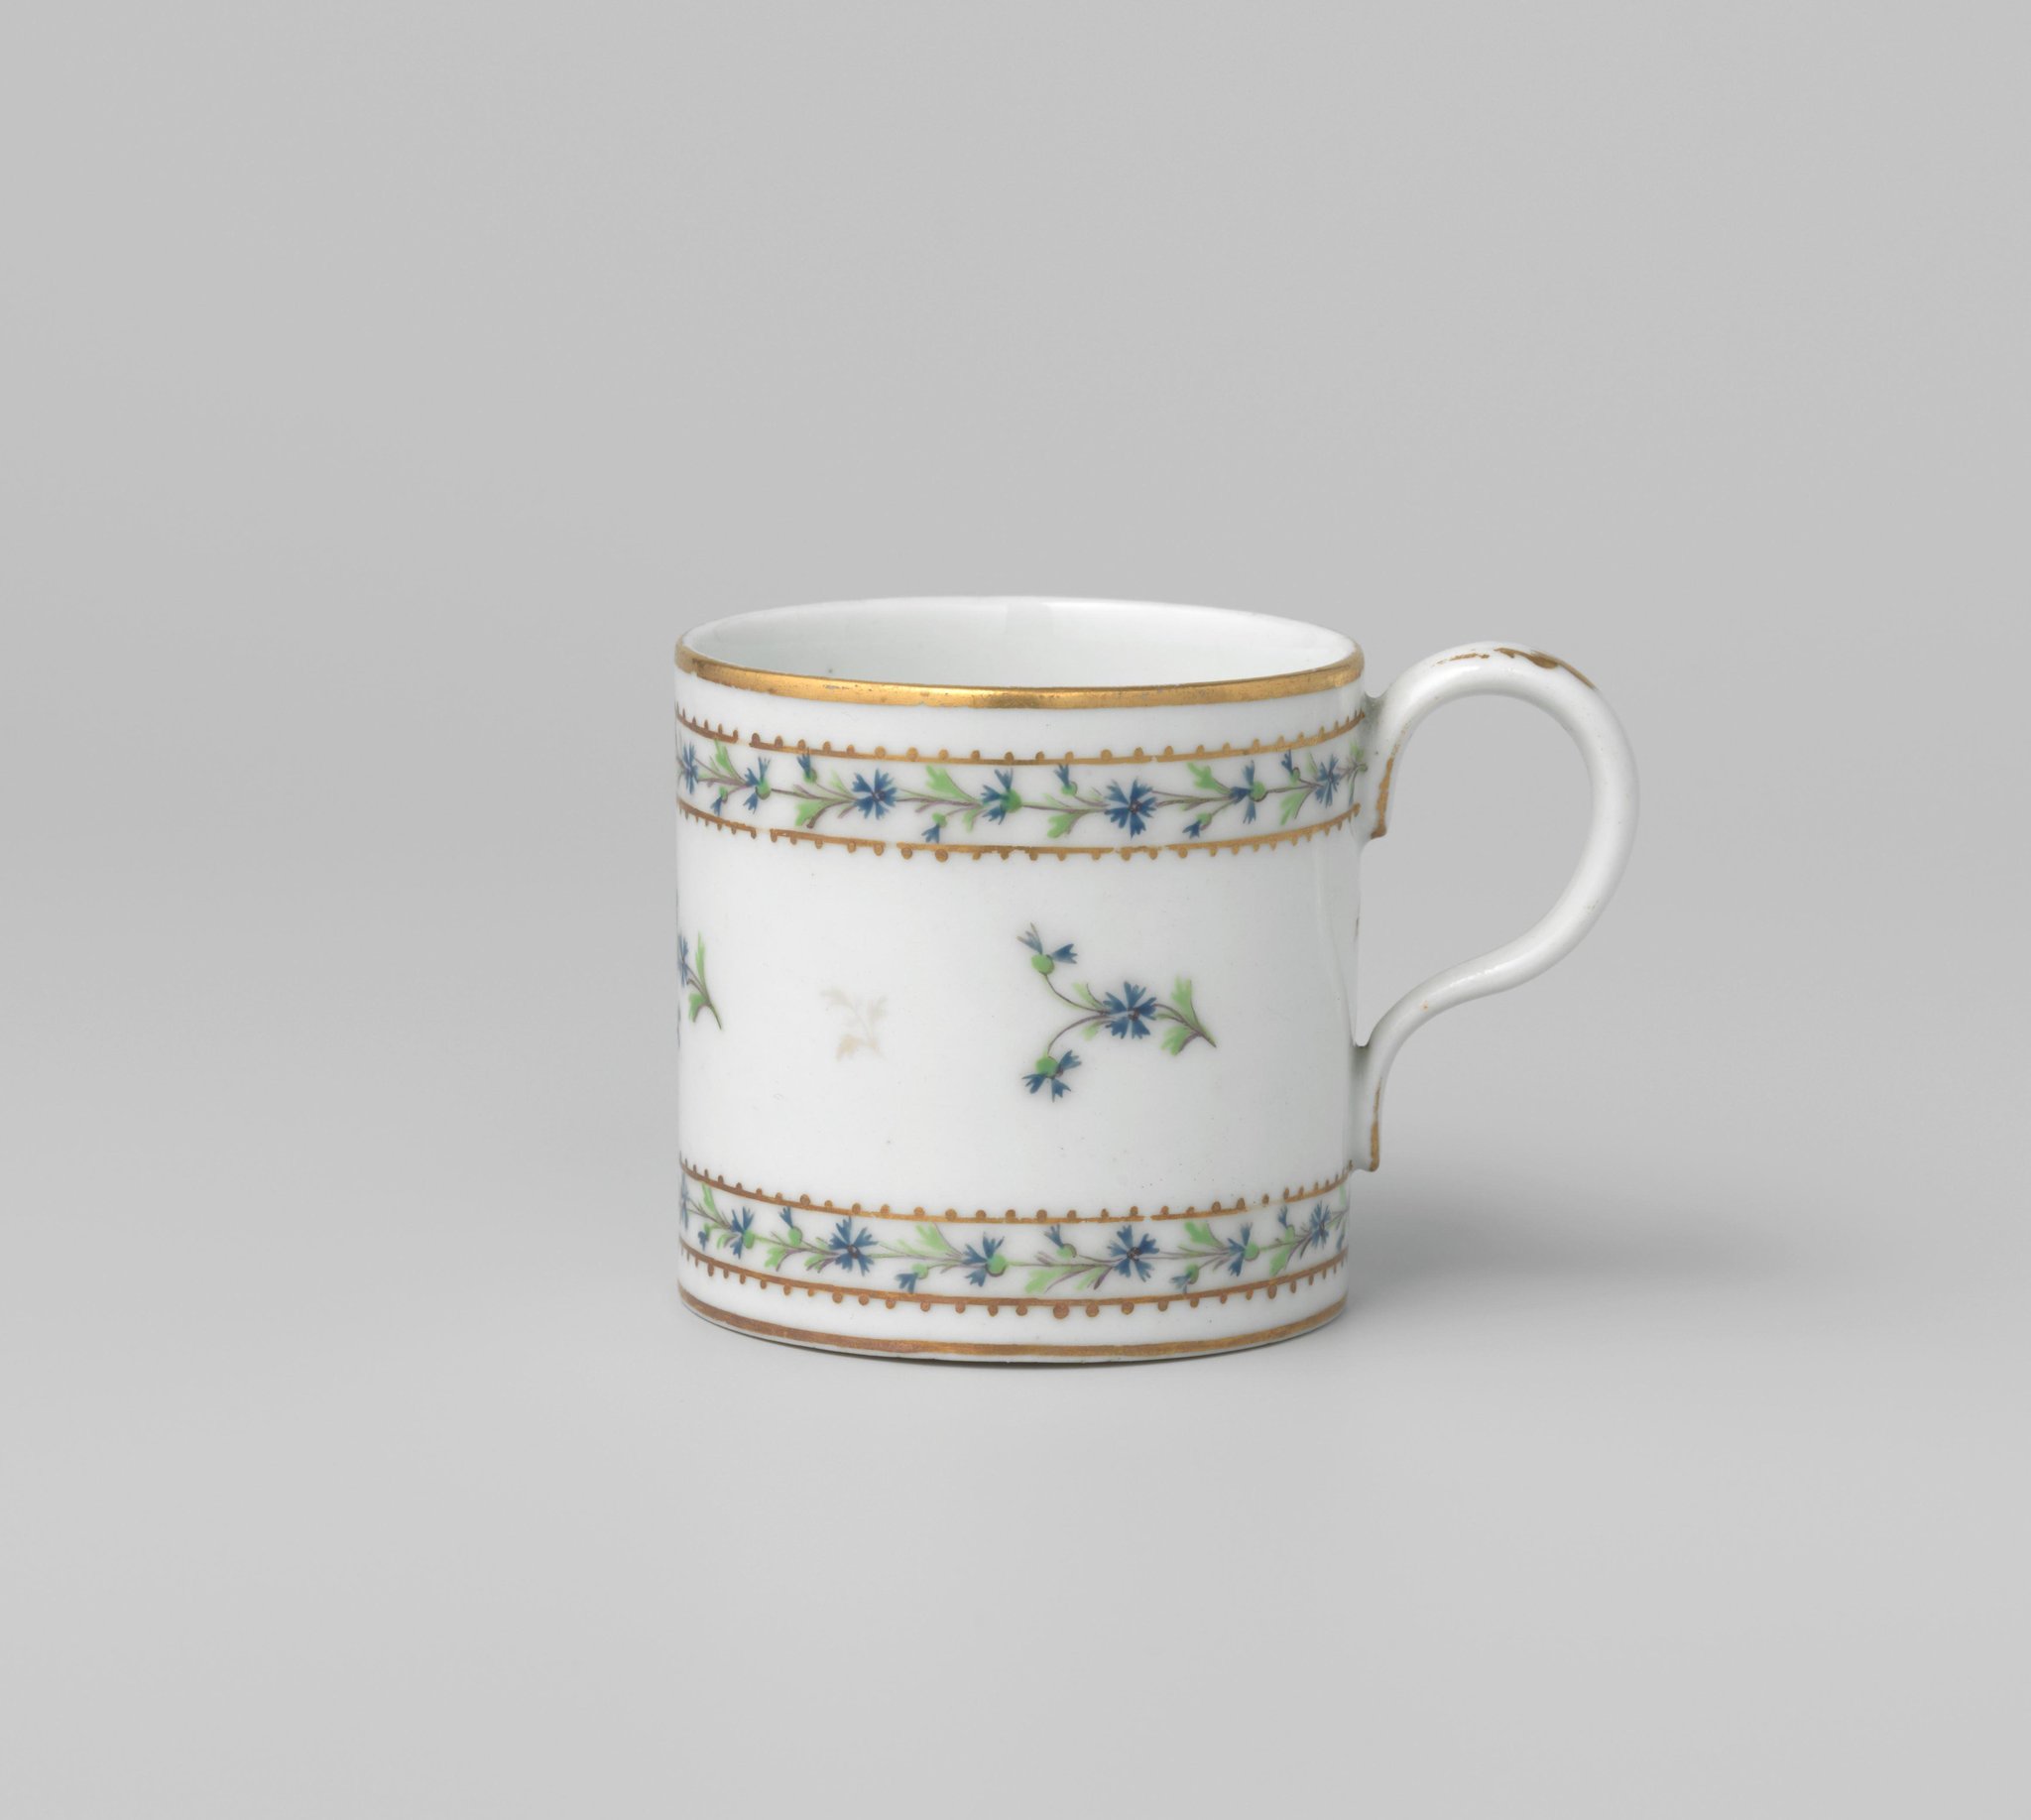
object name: cup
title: Cup with flower sprays and floral scrolls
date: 1790-1800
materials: glaze, gold, paint, porcelain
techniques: firing, gilding, turning, vitrification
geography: niderviller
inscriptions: mark: ‘N100’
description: Kop van porselein met een cilindrische wand en C-vormig oor, beschilderd op het glazuur in blauw, groen, paars en goud. Op de buitenwand bloemtakken (korenbloem), waartussen kleine, gouden takken. Hierboven en -onder een band met een doorlopende bloemrank. Bladmotief op het oor. Gouden rand. Gemerkt op de onderzijde met N100.